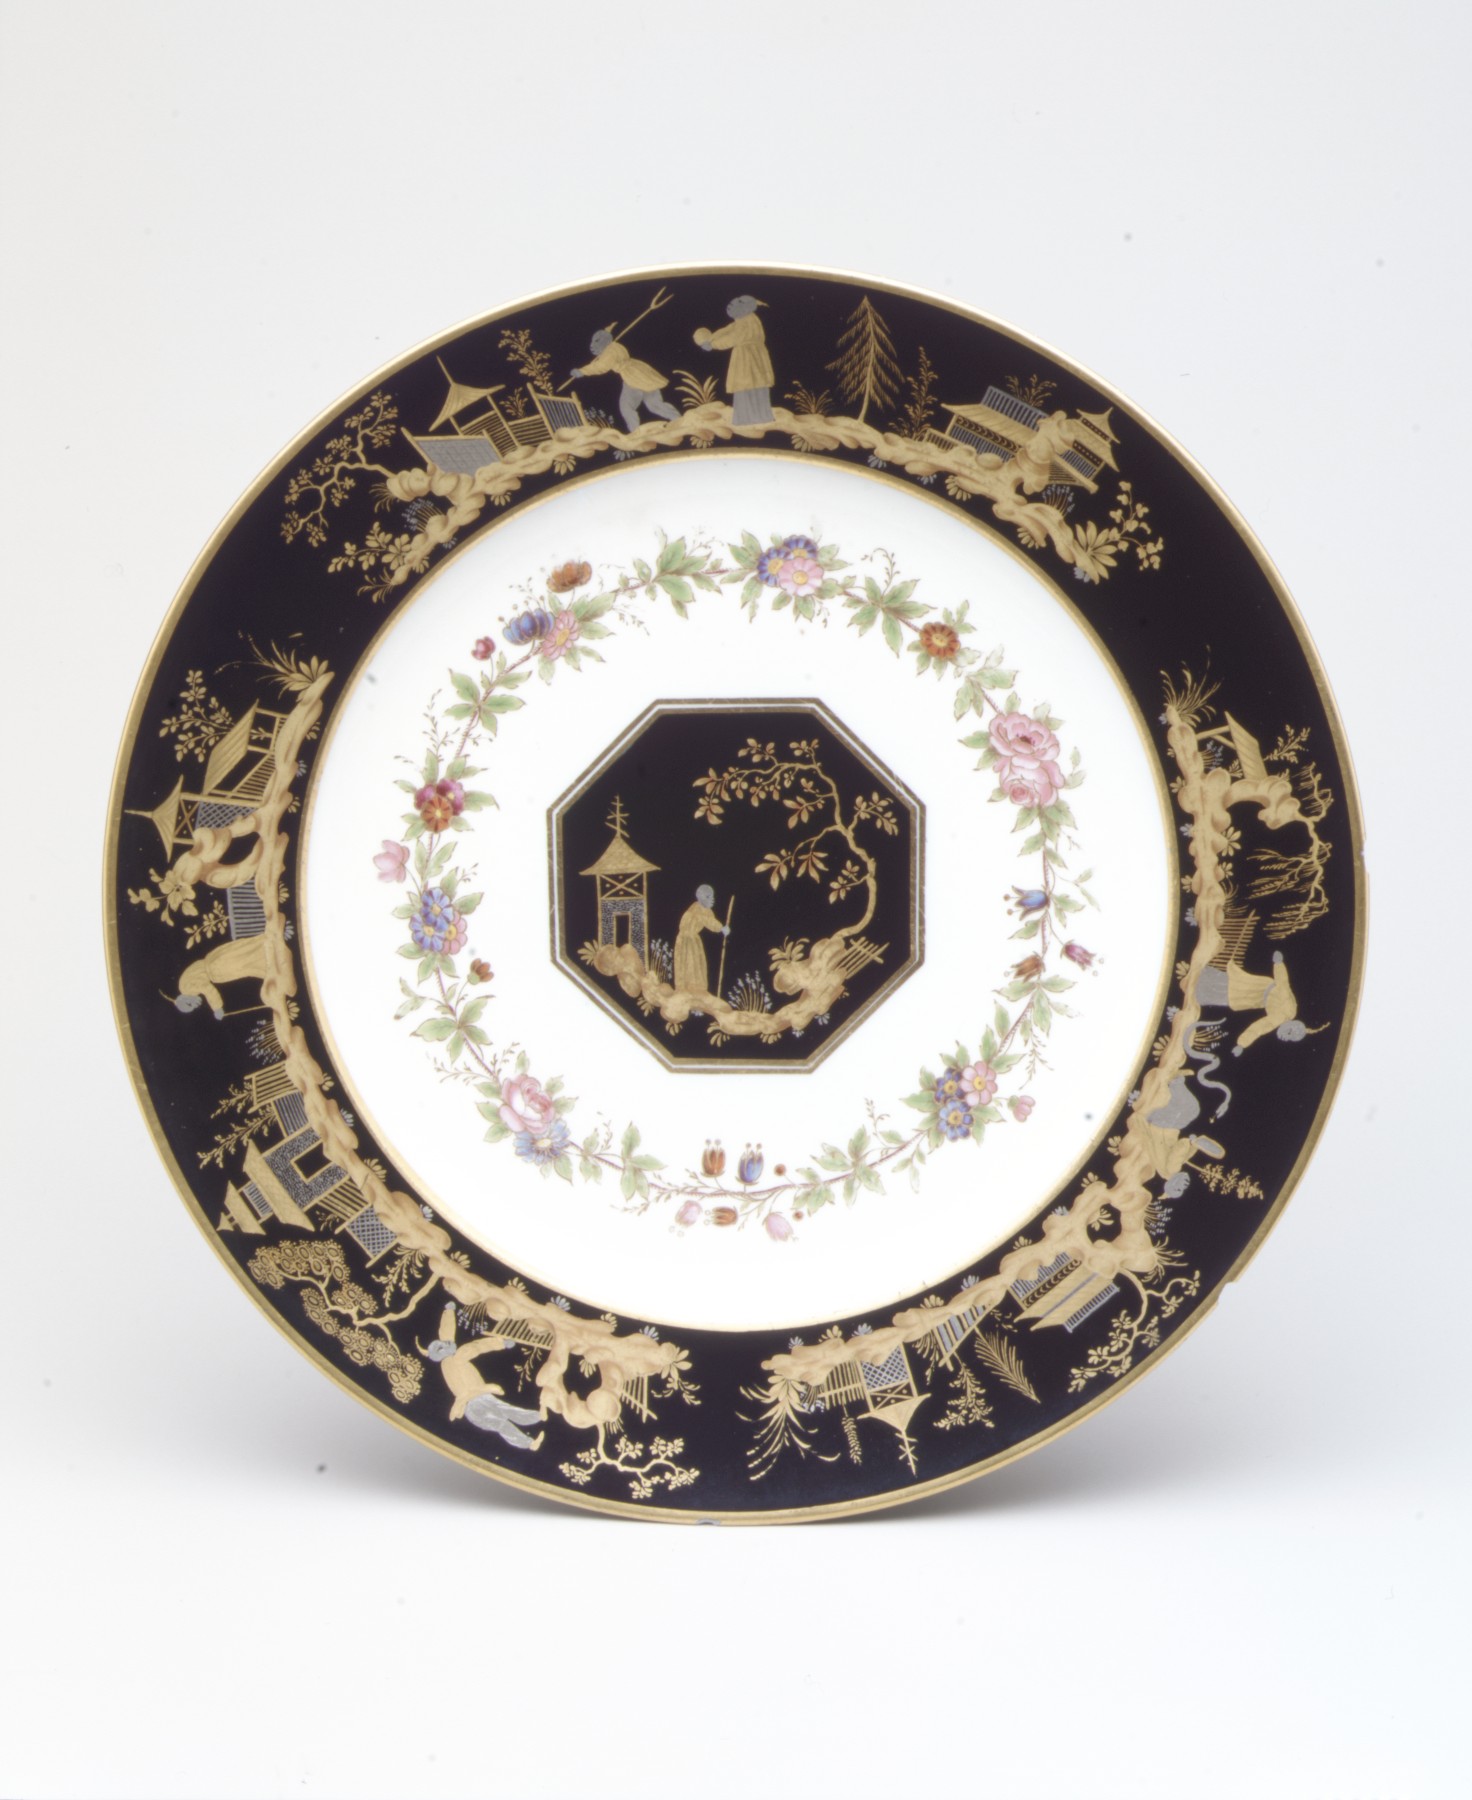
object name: plate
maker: sèvres manufactory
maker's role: manufactory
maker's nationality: french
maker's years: 1740-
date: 1791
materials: hard paste porcelain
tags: chinoiserie,men,flowers